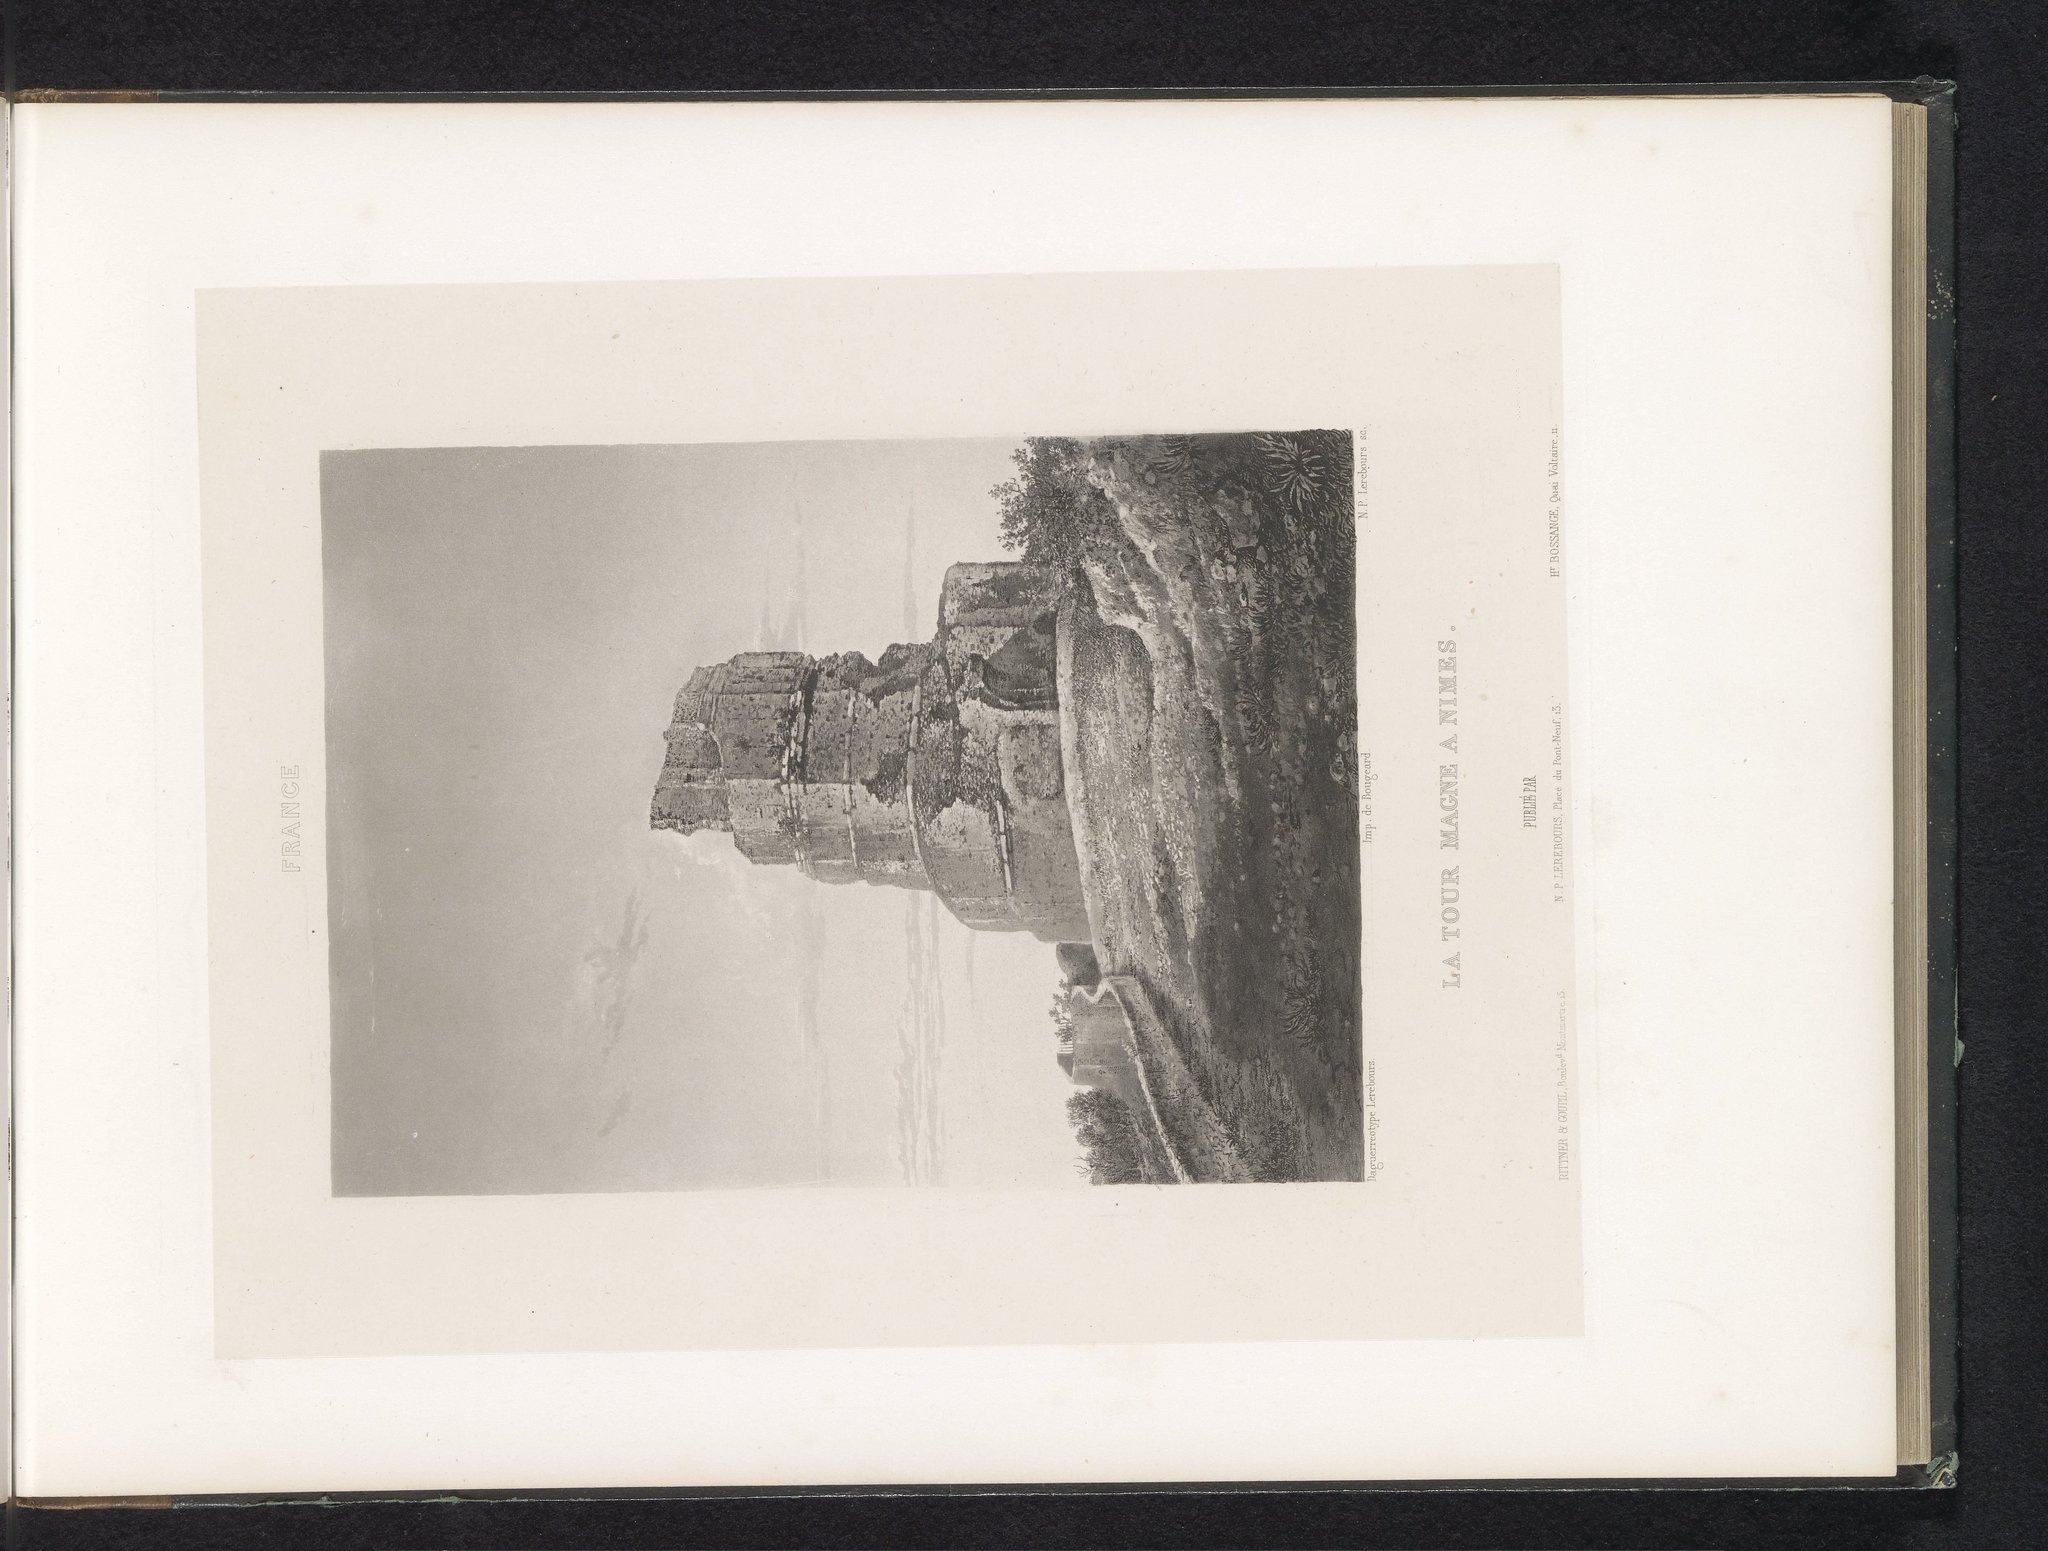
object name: print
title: La Tour Magne a Nimes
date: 1839-1841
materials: paper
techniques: aquatint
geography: paris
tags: tower, clock tower ~ monumental adornment, ruin of a building ~ architecture, façade (of house or building)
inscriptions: inscription: ‘N.P. Lerebours Place du Pont Neuf 15’, inscription: ‘Hr. Bossance Quai Voltaire 11’, inscription: ‘Rittner & Goupil Boulevd Montmartre 15’